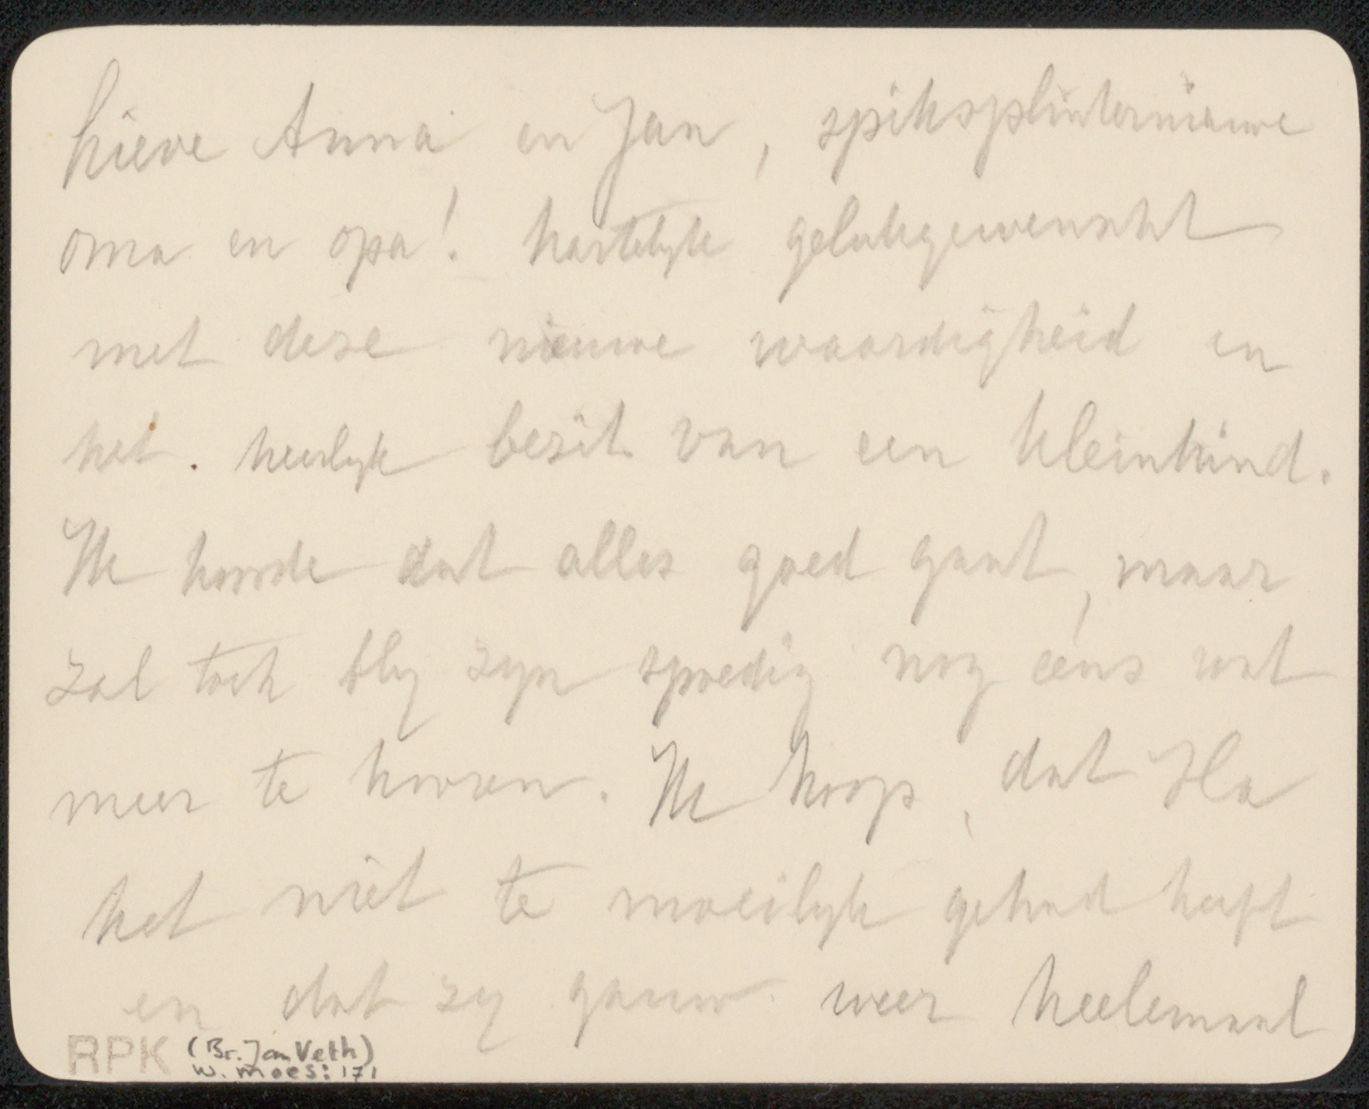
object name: letter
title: Brief aan Anna Dorothea Dirks en Jan Veth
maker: wally moes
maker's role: draughtsman, print maker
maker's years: 1856-1918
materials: paper, pencil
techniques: writing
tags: dordrecht, painter, print maker, draughtsman, designer, jan veth, artist, anna dorothea dirks, family life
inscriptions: collector's mark: ‘RPK’